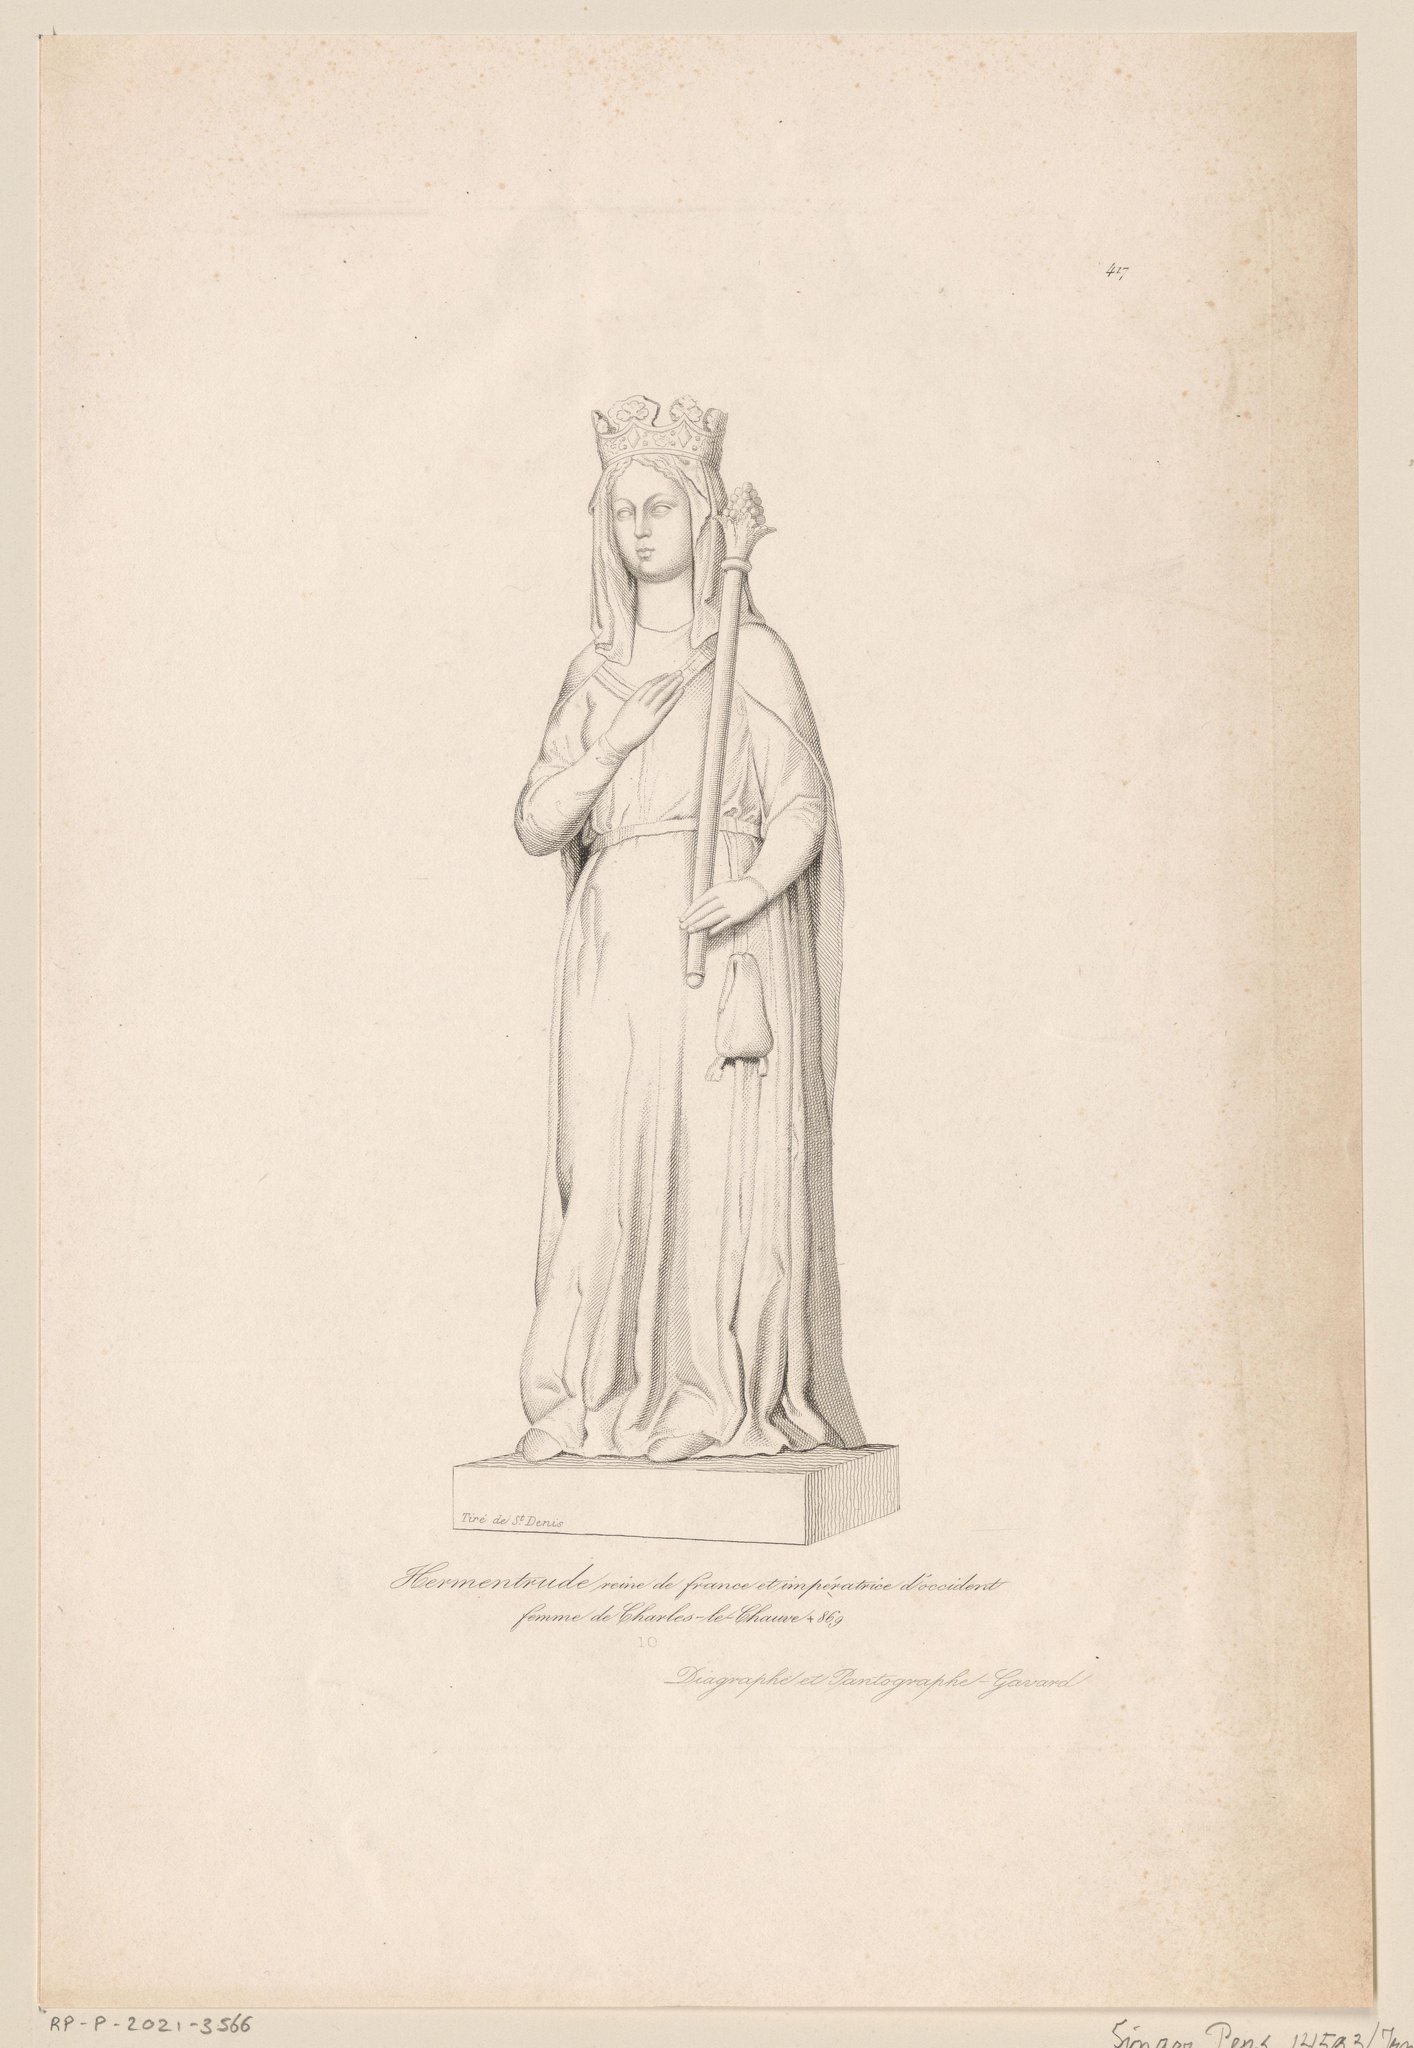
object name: print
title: Portret van Ermentrudis van Orléans, koningin van Frankrijk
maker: charles gavard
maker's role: print maker, publisher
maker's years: 1794-1871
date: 1804-1871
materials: paper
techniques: engraving, etching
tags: historical persons - bb - woman, queen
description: Midden onder genummerd: 10. Rechtsboven genummerd: 417.